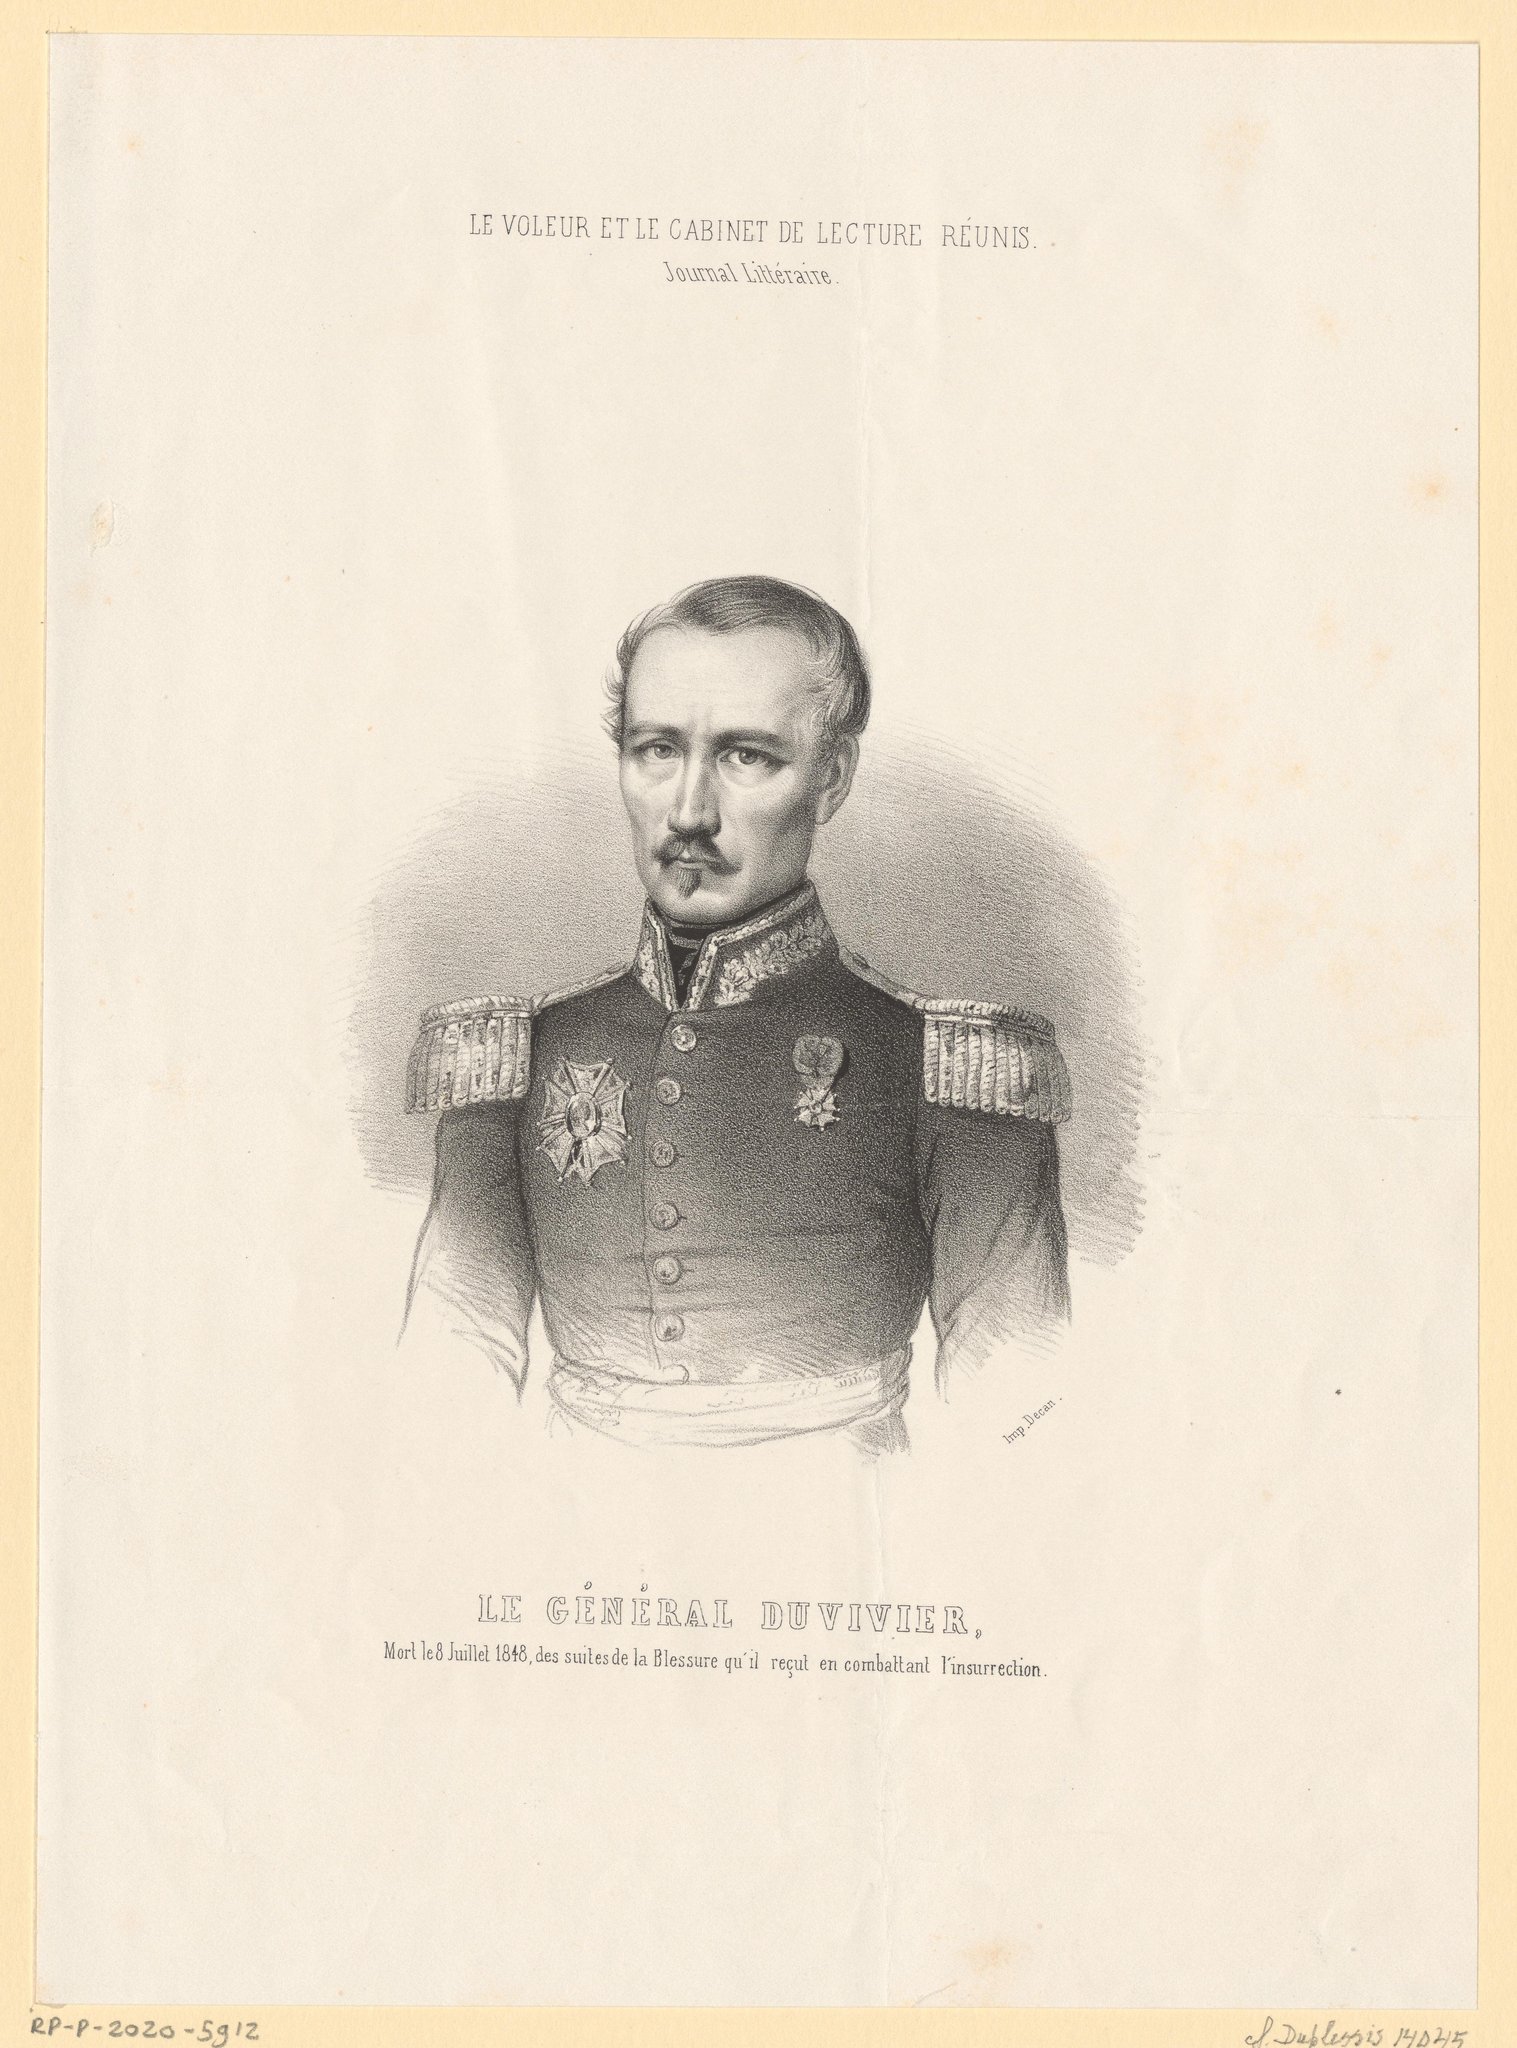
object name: print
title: Portret van Franciade Fleurus Duvivier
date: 1848-1853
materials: paper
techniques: lithograph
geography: paris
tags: paris, commander-in-chief, general, marshal, historical persons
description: Prent uit: Le voleur et le cabinet de lecture réunis, 1842-1856.